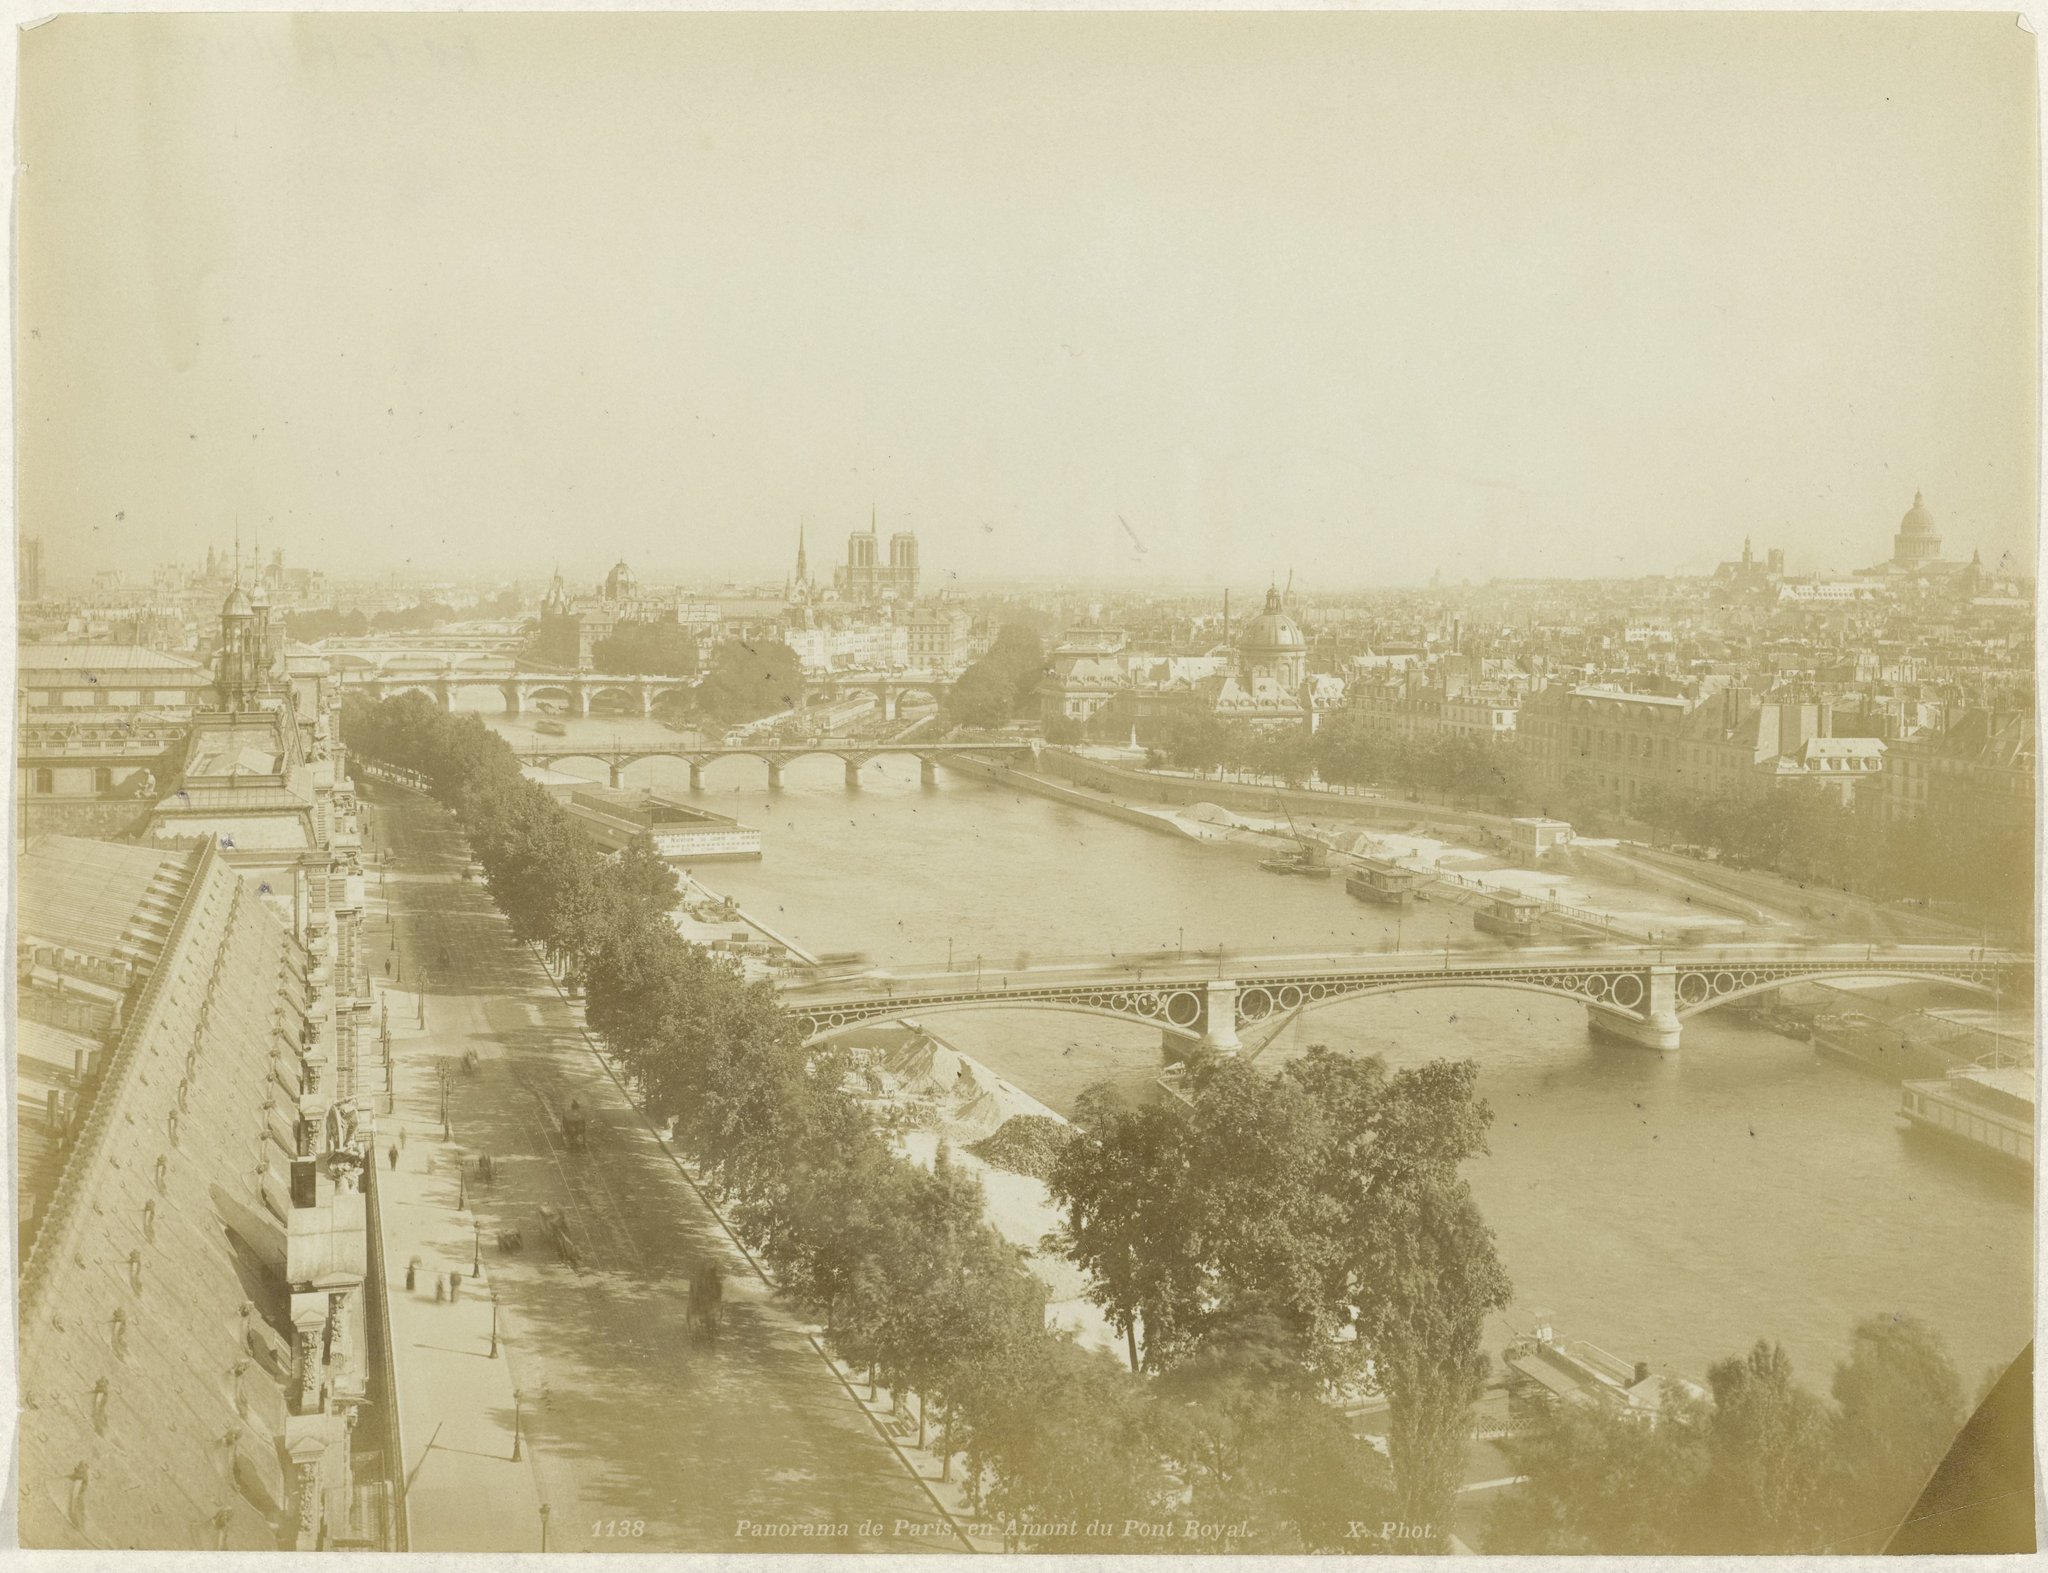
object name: photograph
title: Gezicht over Parijs en de Seine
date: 1887-1900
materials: paper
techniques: albumen print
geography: paris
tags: city-view in general; 'veduta', bridge in city across river, canal, etc., paris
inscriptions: inscription: ‘1138 Panorama de Paris, en Amont du Pont Royal. X. Phot.’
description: Tussen 1887 en ca. 1900 werkten Neurdein frères onder andere onder de naam 'X phot.'.